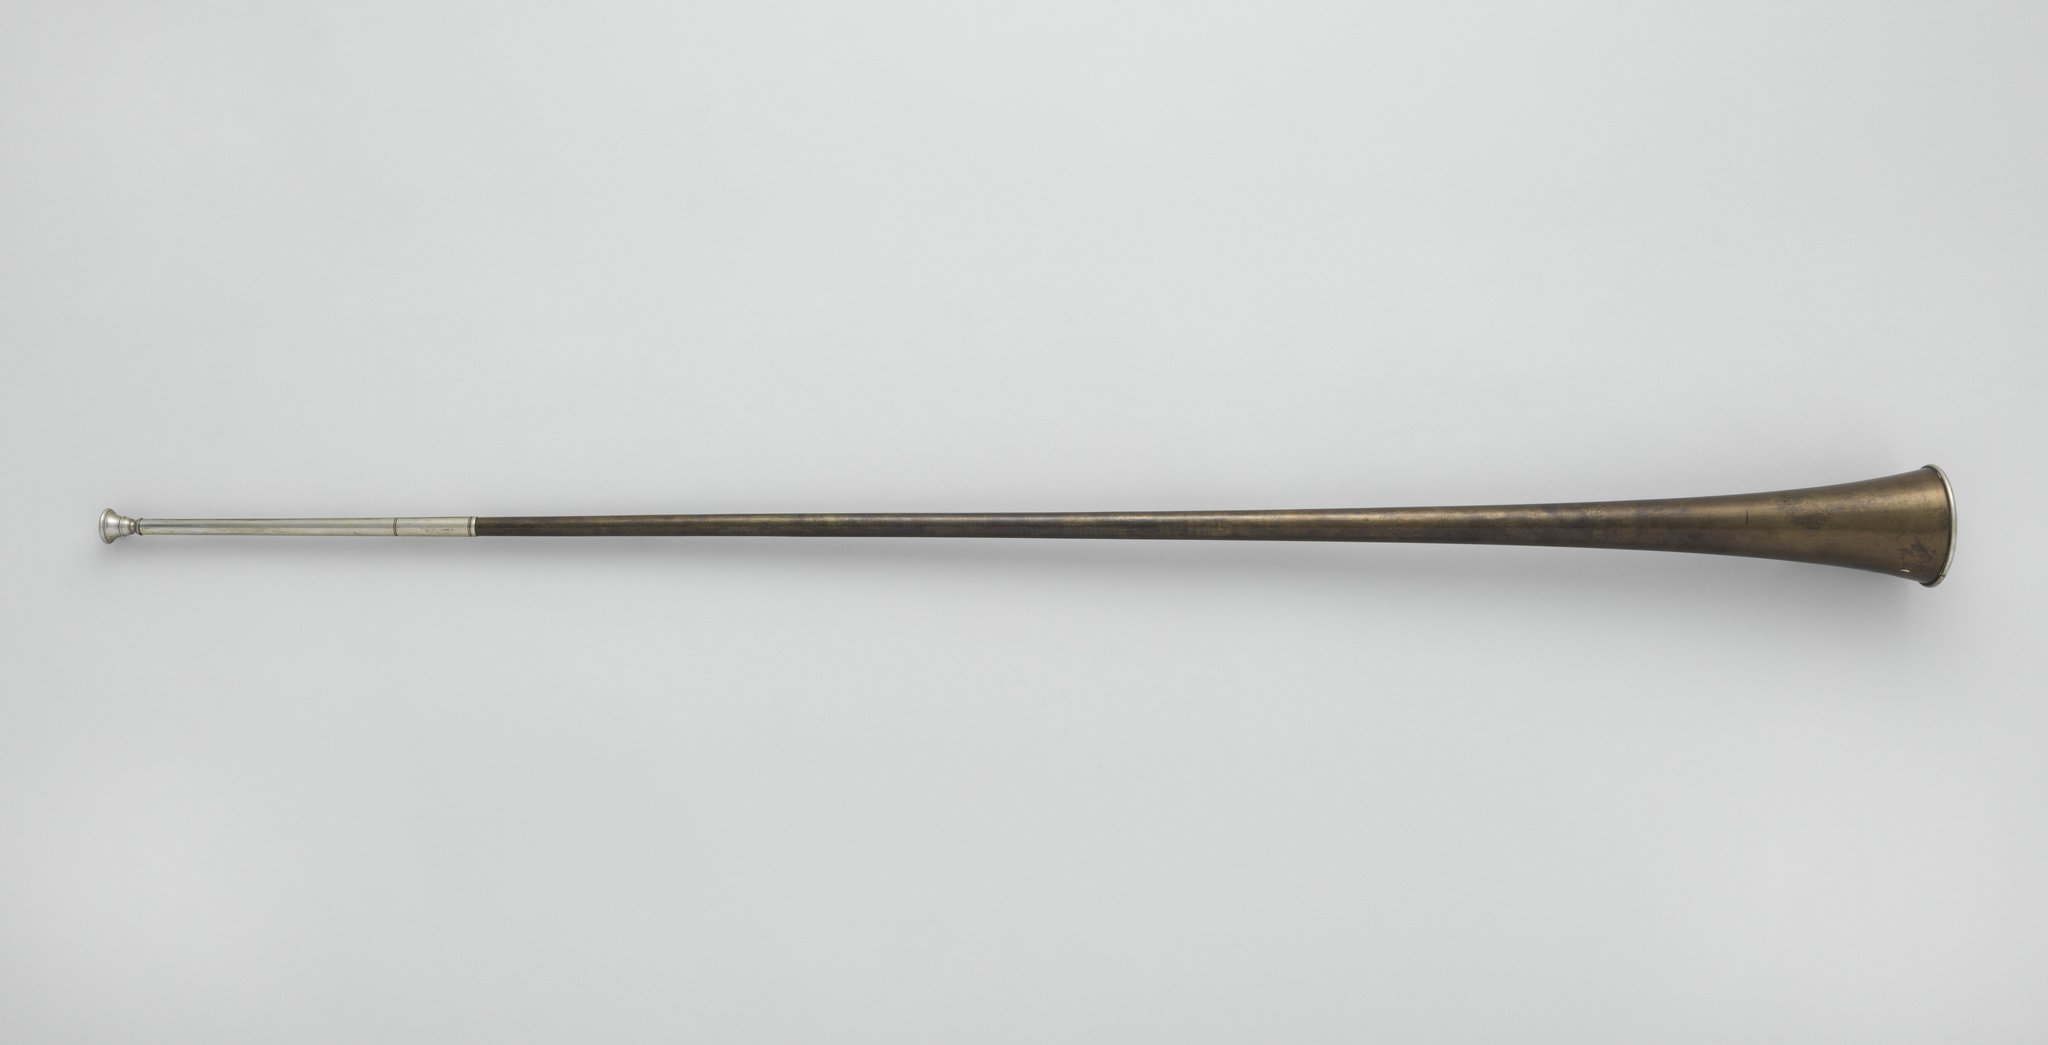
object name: coach horn in c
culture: european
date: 1825-1889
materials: brass, nickel, silver